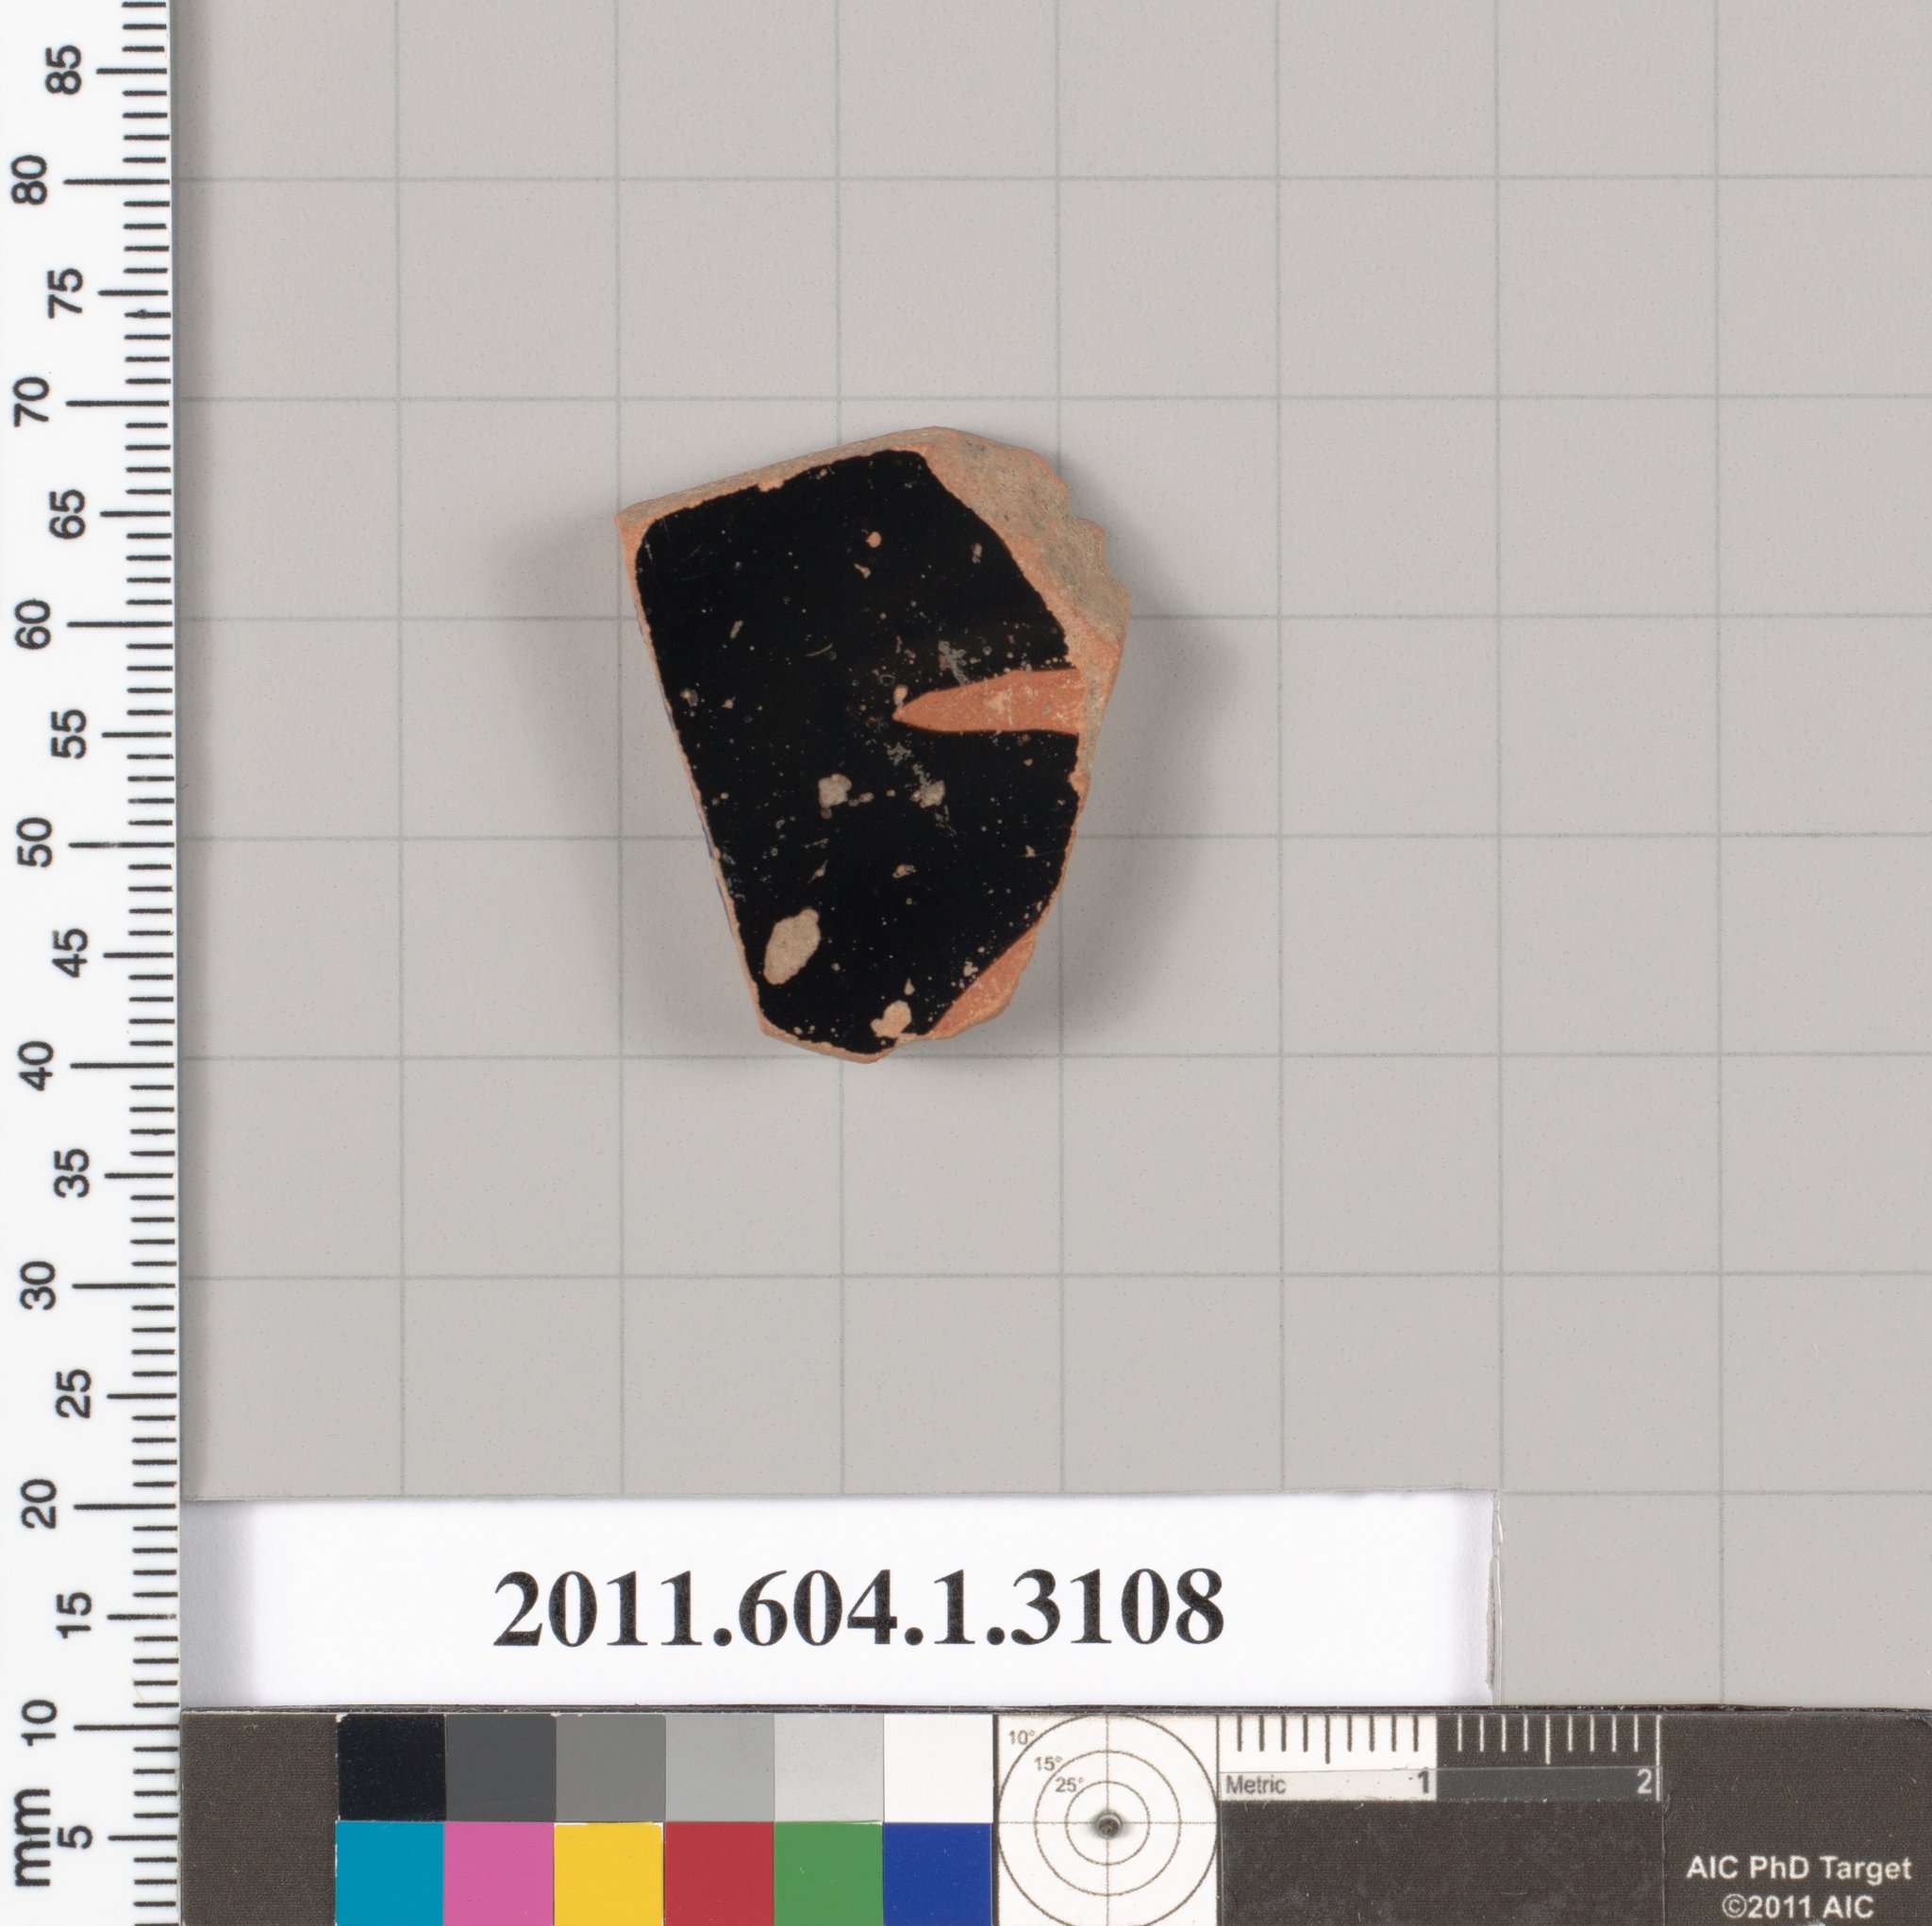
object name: kylix fragment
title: Terracotta fragment of a kylix (drinking cup)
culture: greek, attic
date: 500-451 BCE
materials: terracotta